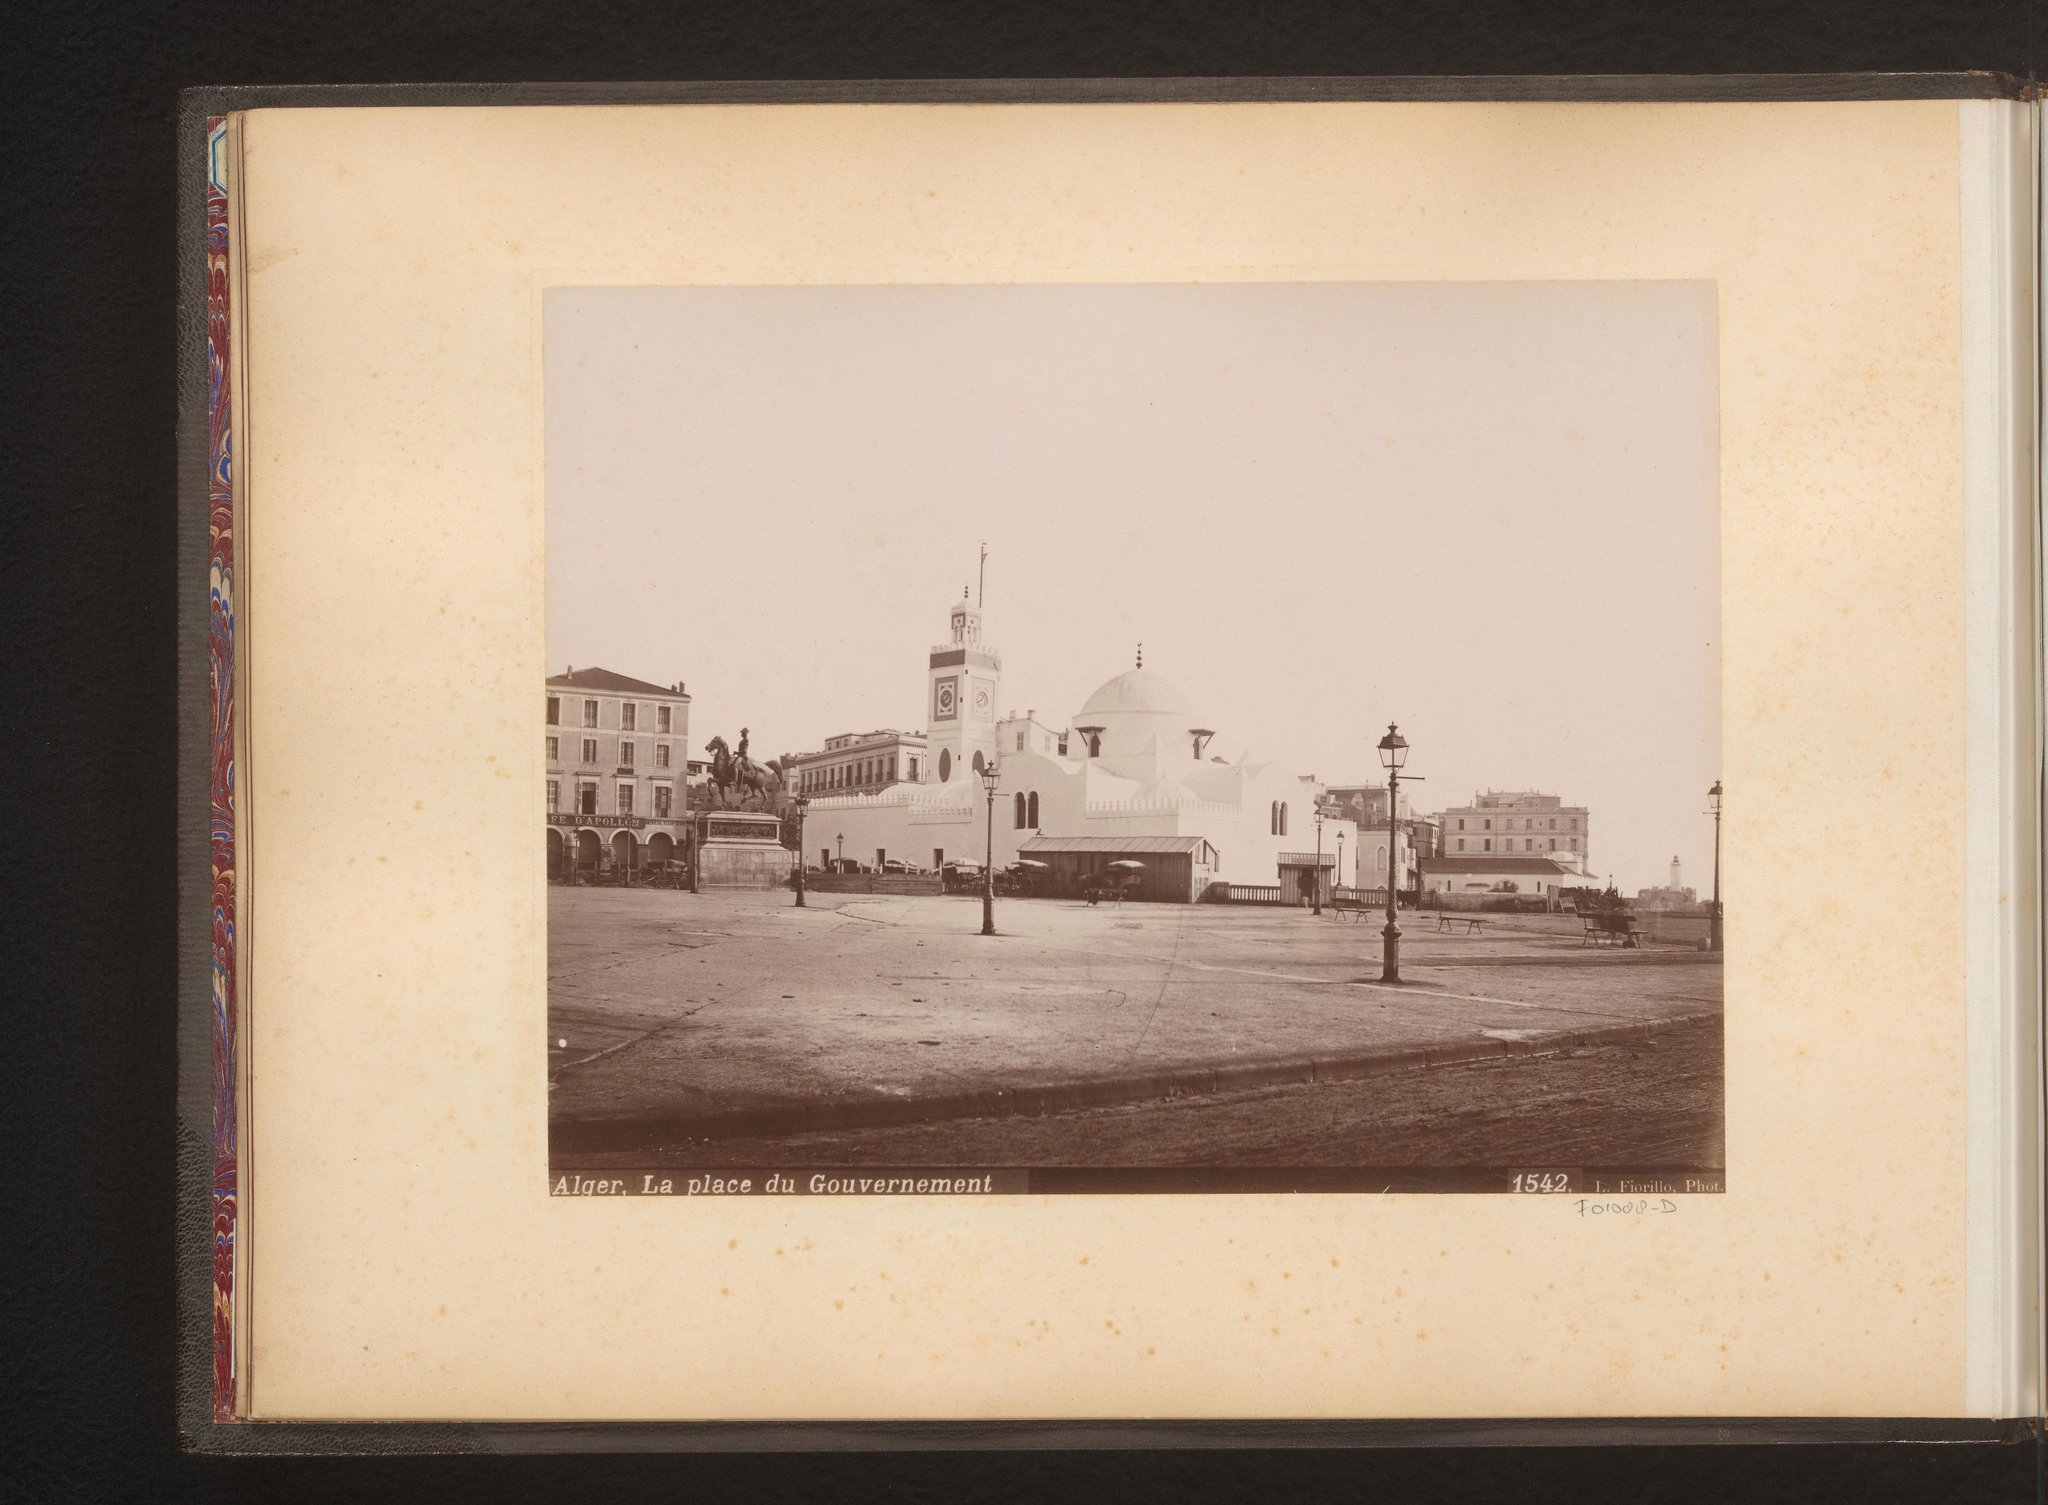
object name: photograph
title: Gezicht op Place du Gouvernement te Algiers met de Djama’a al-Djedid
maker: luigi fiorillo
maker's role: fotograaf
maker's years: 1847-1898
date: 1870-1895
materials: photographic support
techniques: albumen print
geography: algiers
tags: square, place, circus, etc., temple, shrine ~ islam, mohammedanism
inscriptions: number: ‘1542’